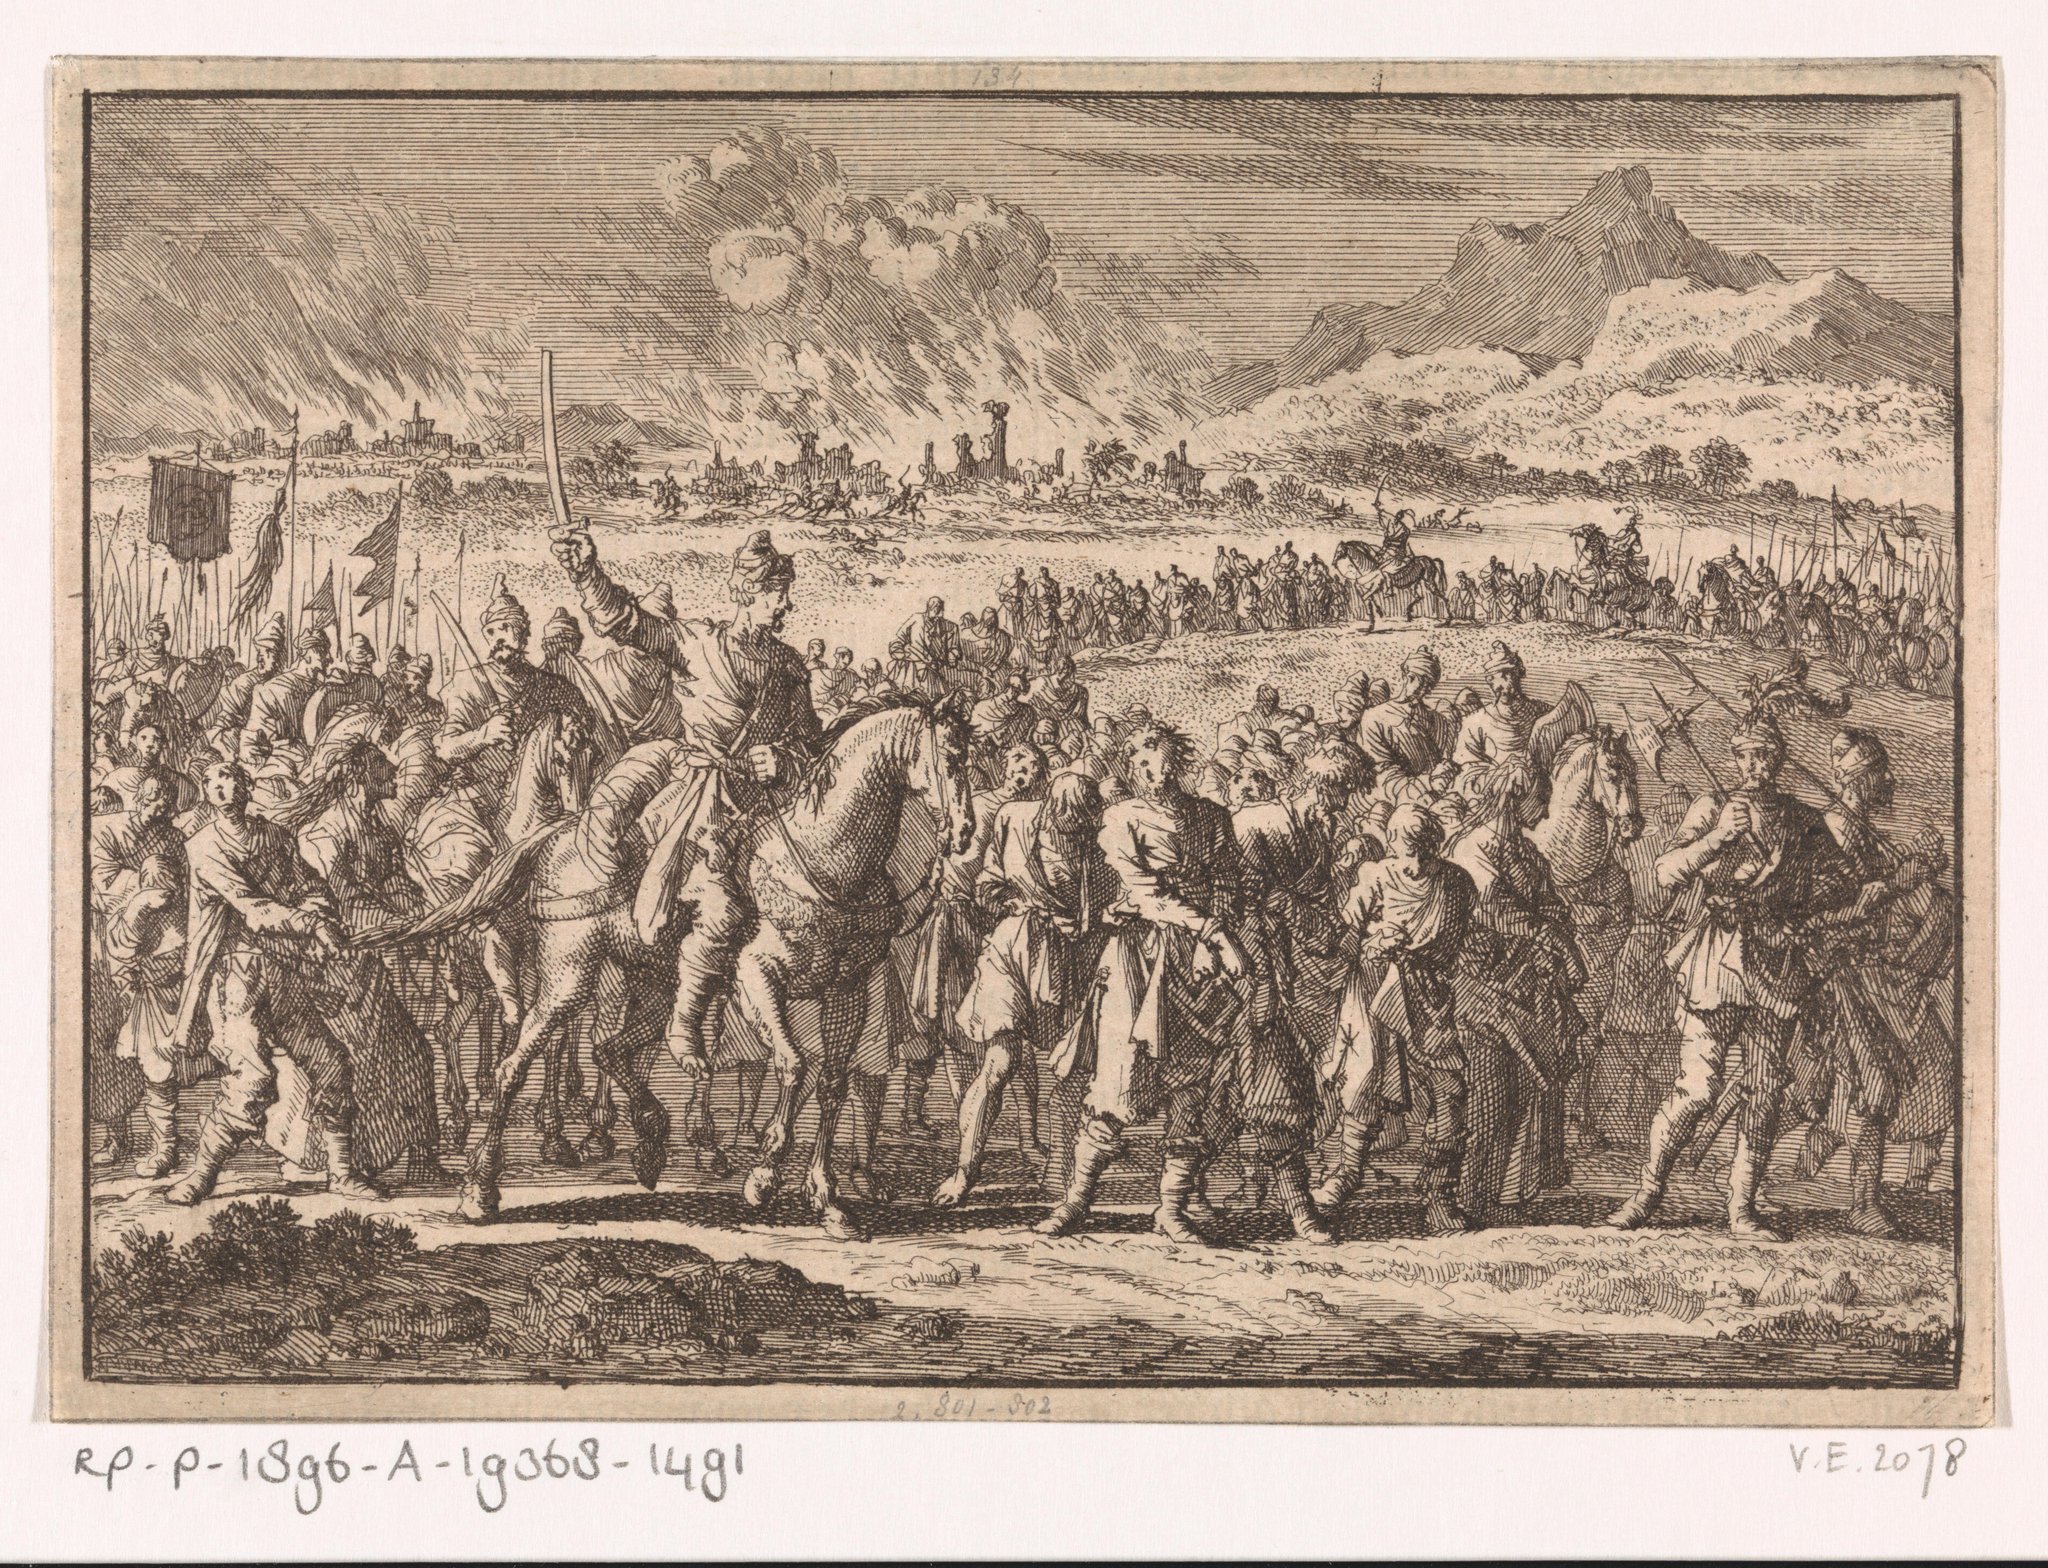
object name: book illustration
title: Inval van de Tartaren in Polen, 1666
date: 1698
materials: paper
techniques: etching, letterpress printing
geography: leiden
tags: occupation ~ war, poland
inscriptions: collector's mark: Lugt 2228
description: Illustratie uit: Gottfried, Johann Ludwig. Historische kronyck; vervattende een (...) beschrijvingh der aldergedenckwaerdigste geschiedenissen des weerelds, van den aenvangh der scheppingh tot (...) 1576 (2 delen). Leiden: Pieter van der Aa, 1698, dl. II, p. 801.